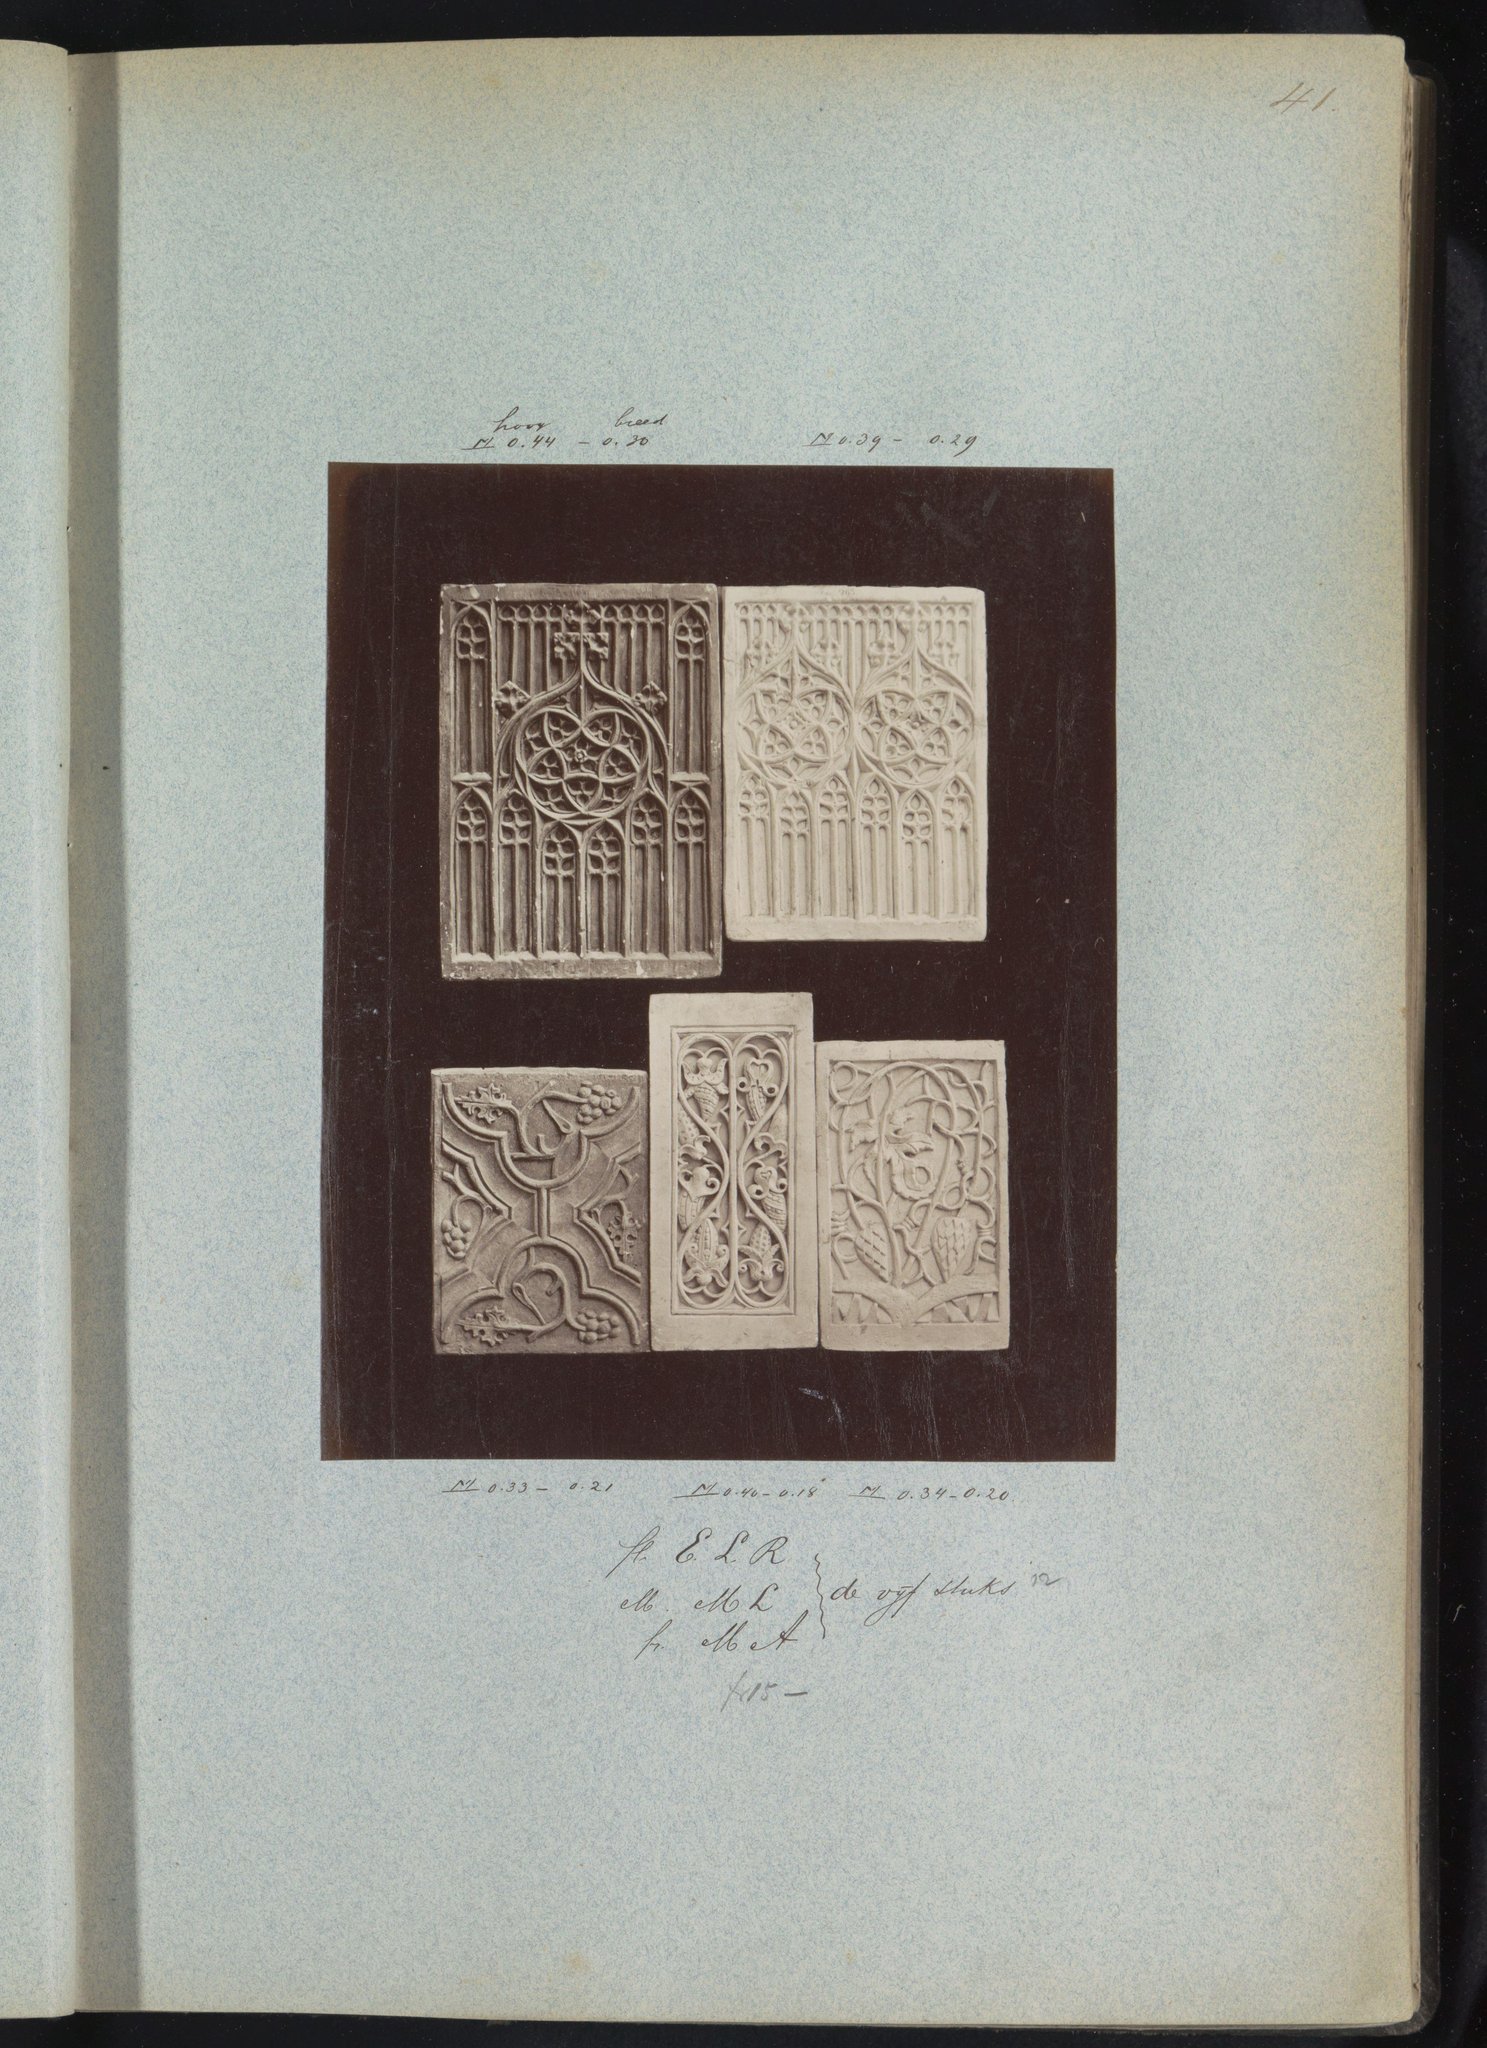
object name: photograph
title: Vijf geornamenteerde gipsen panelen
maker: Anonymous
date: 1875-1900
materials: paper, photographic support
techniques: albumen print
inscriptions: annotation, annotation: ‘M 0.44 hoog - 0.20 breed M 0.39 - 0.29 / M 0.33 - 0.21 M 0.40 - 0.18 M 0.34 - 0.20’